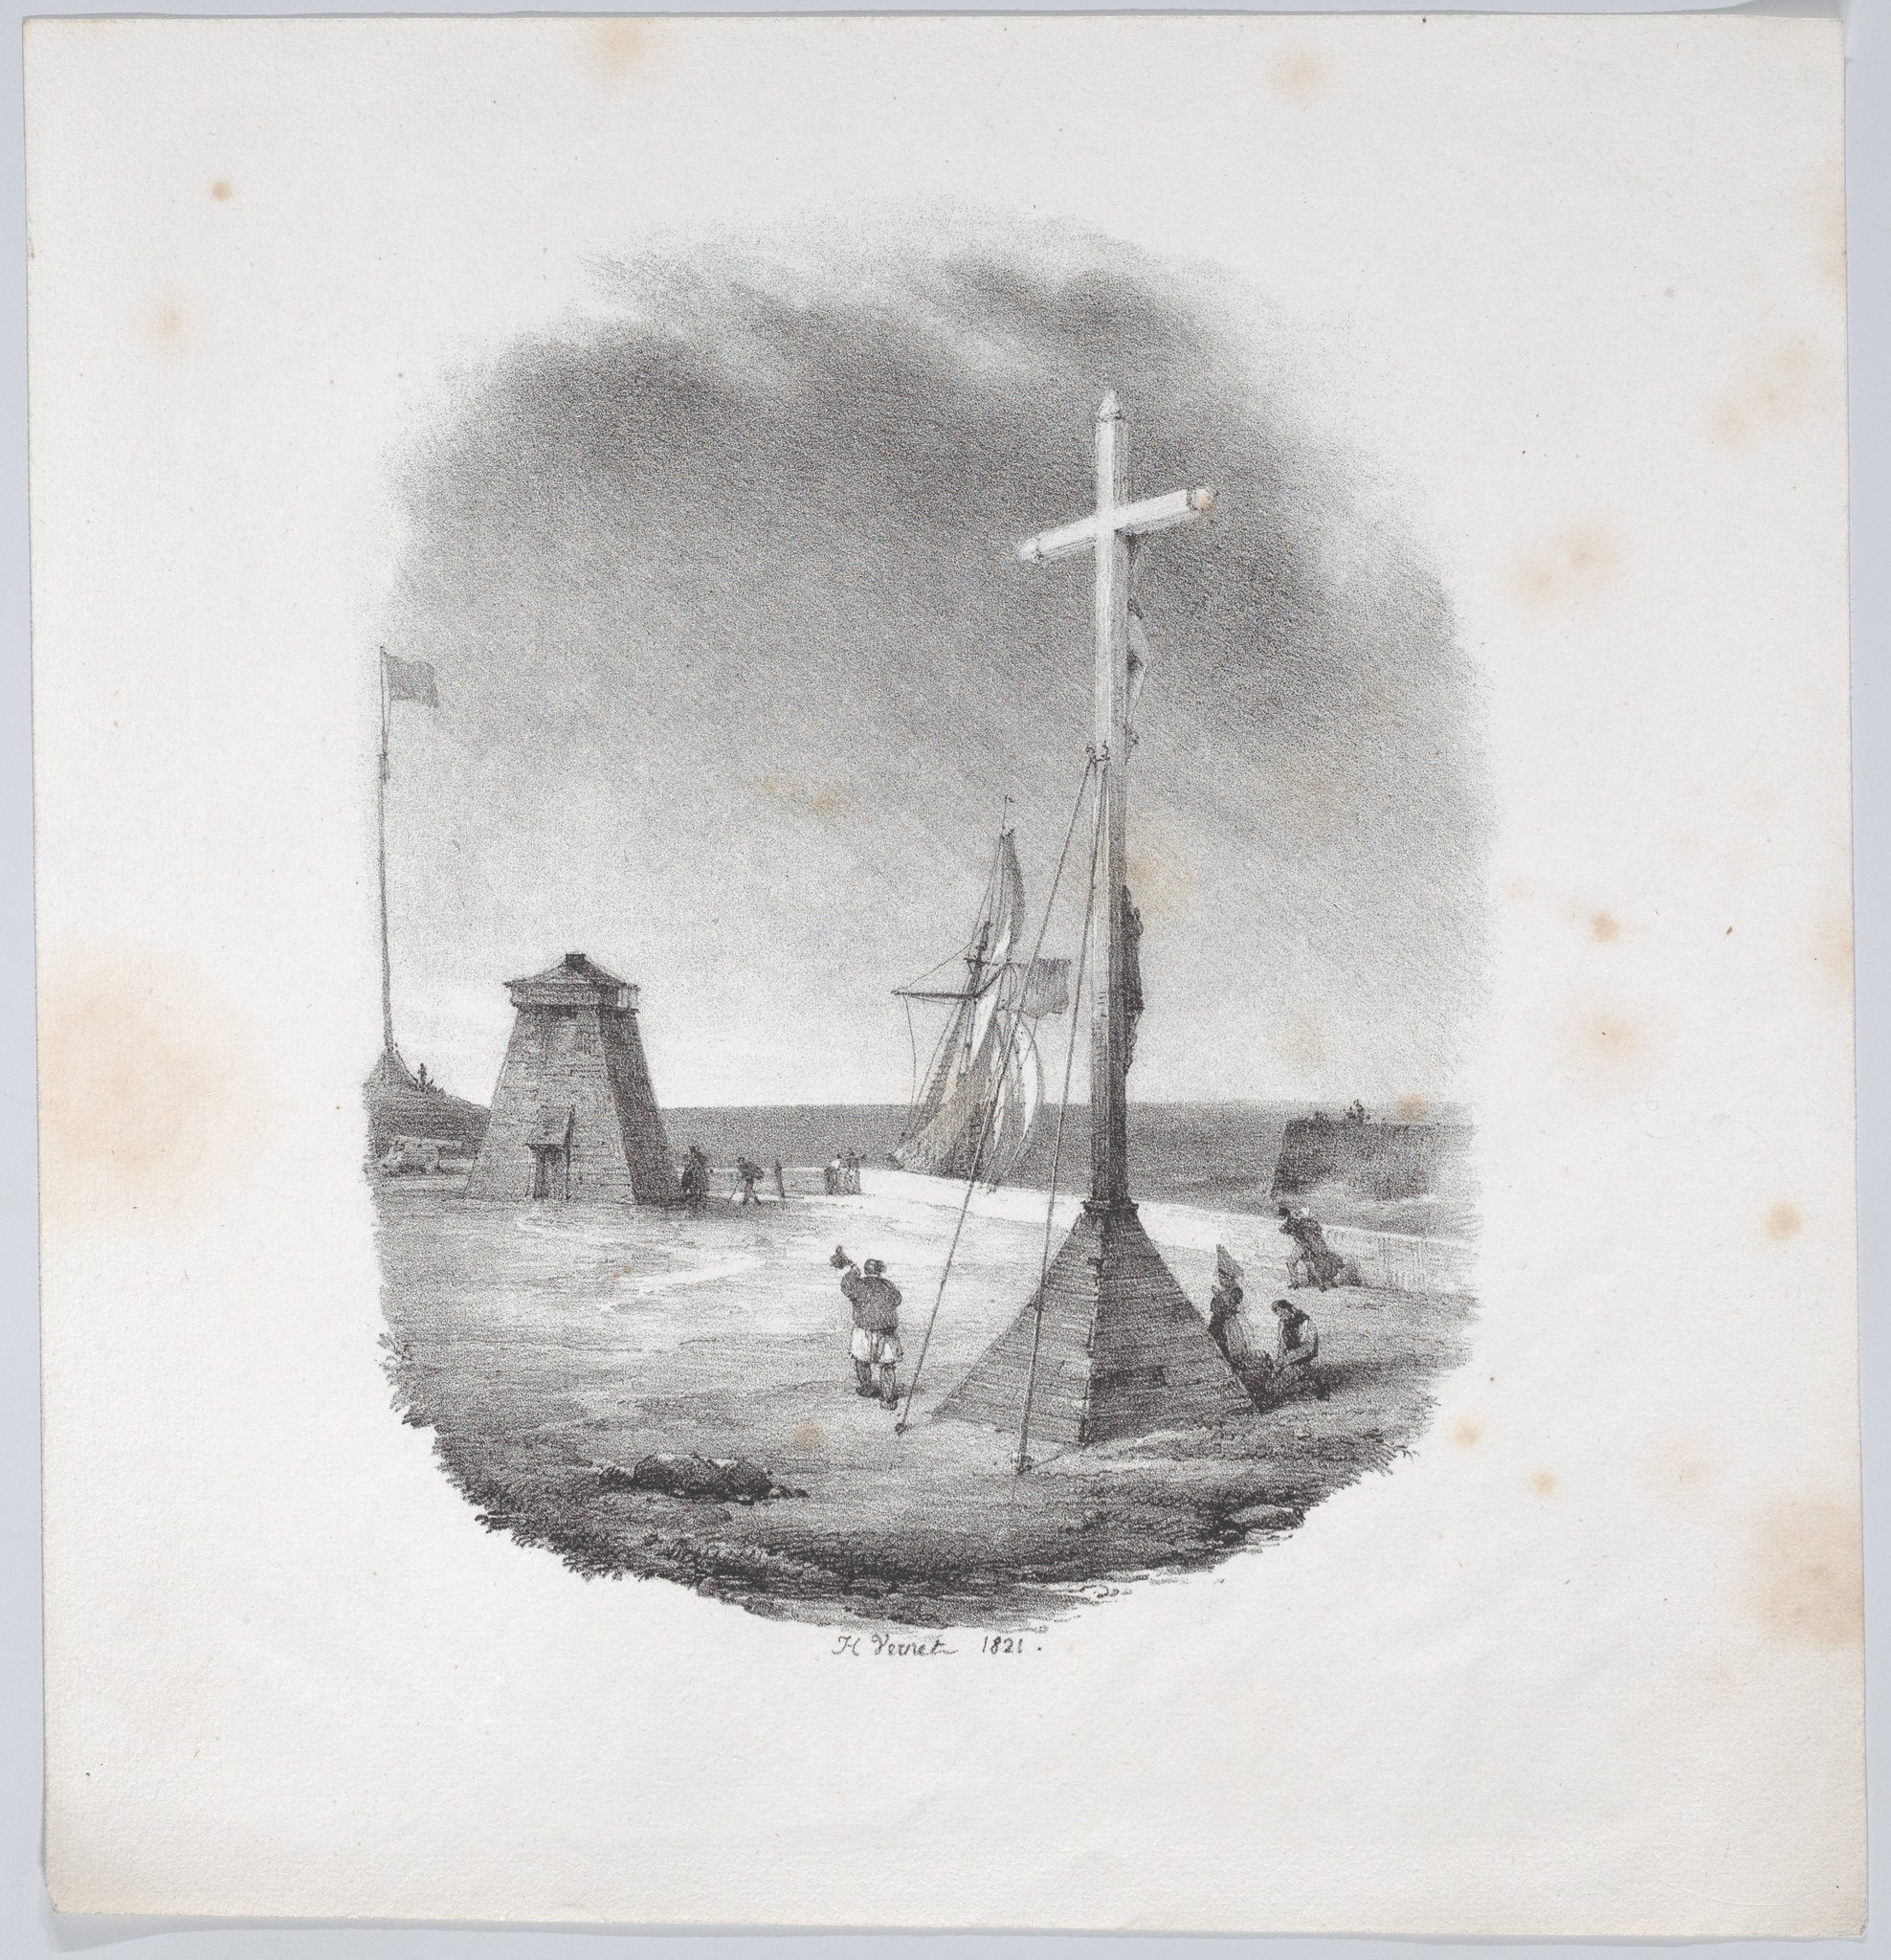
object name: print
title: The Cross of the Sailors–Dieppe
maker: horace vernet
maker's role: artist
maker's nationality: french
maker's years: 1789-1863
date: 1821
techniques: lithograph